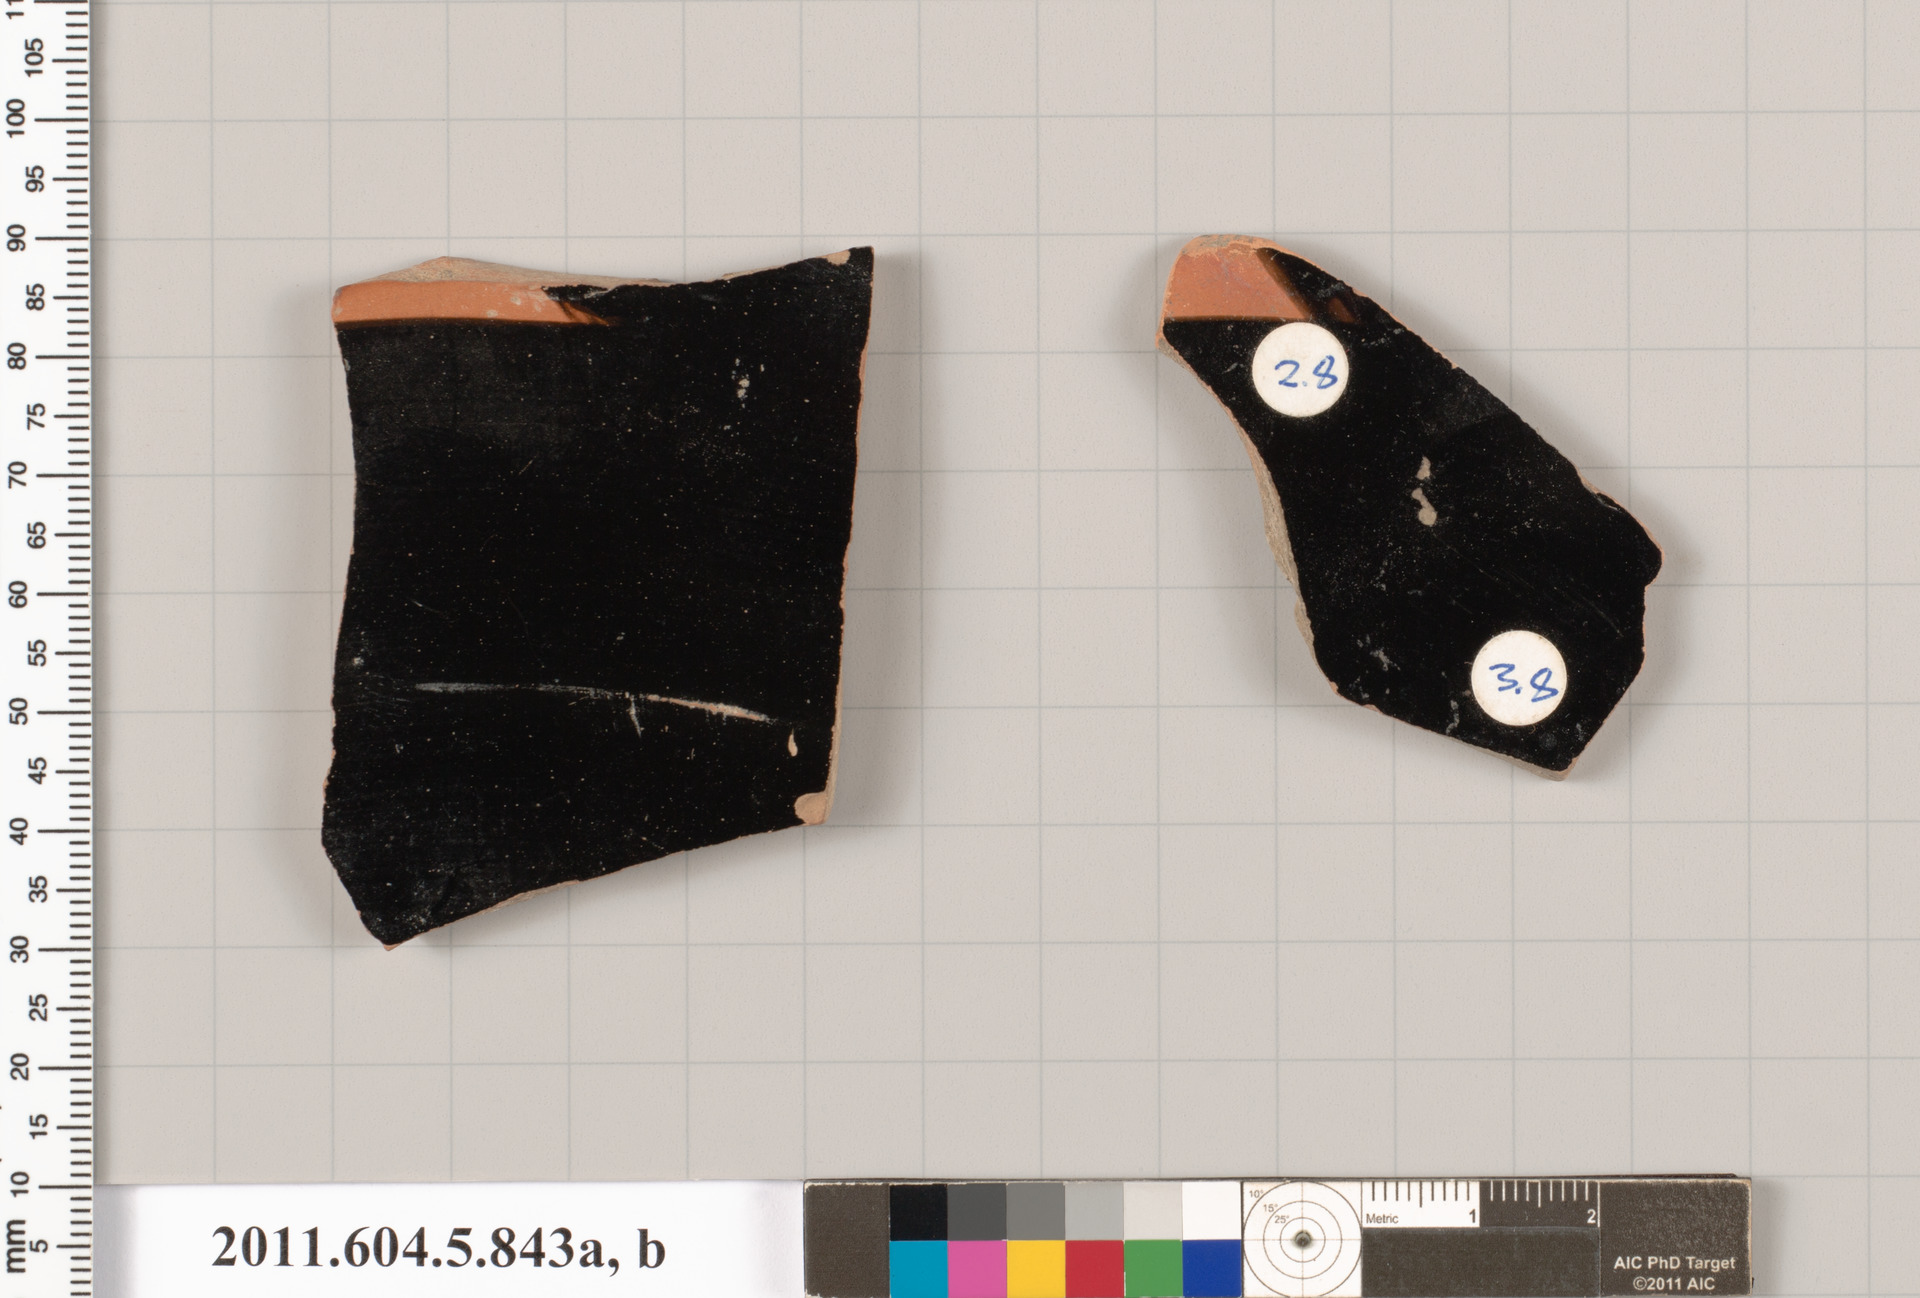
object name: kylix fragment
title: Terracotta fragments of kylikes (drinking cups)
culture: greek, attic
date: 600-401 BCE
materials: terracotta